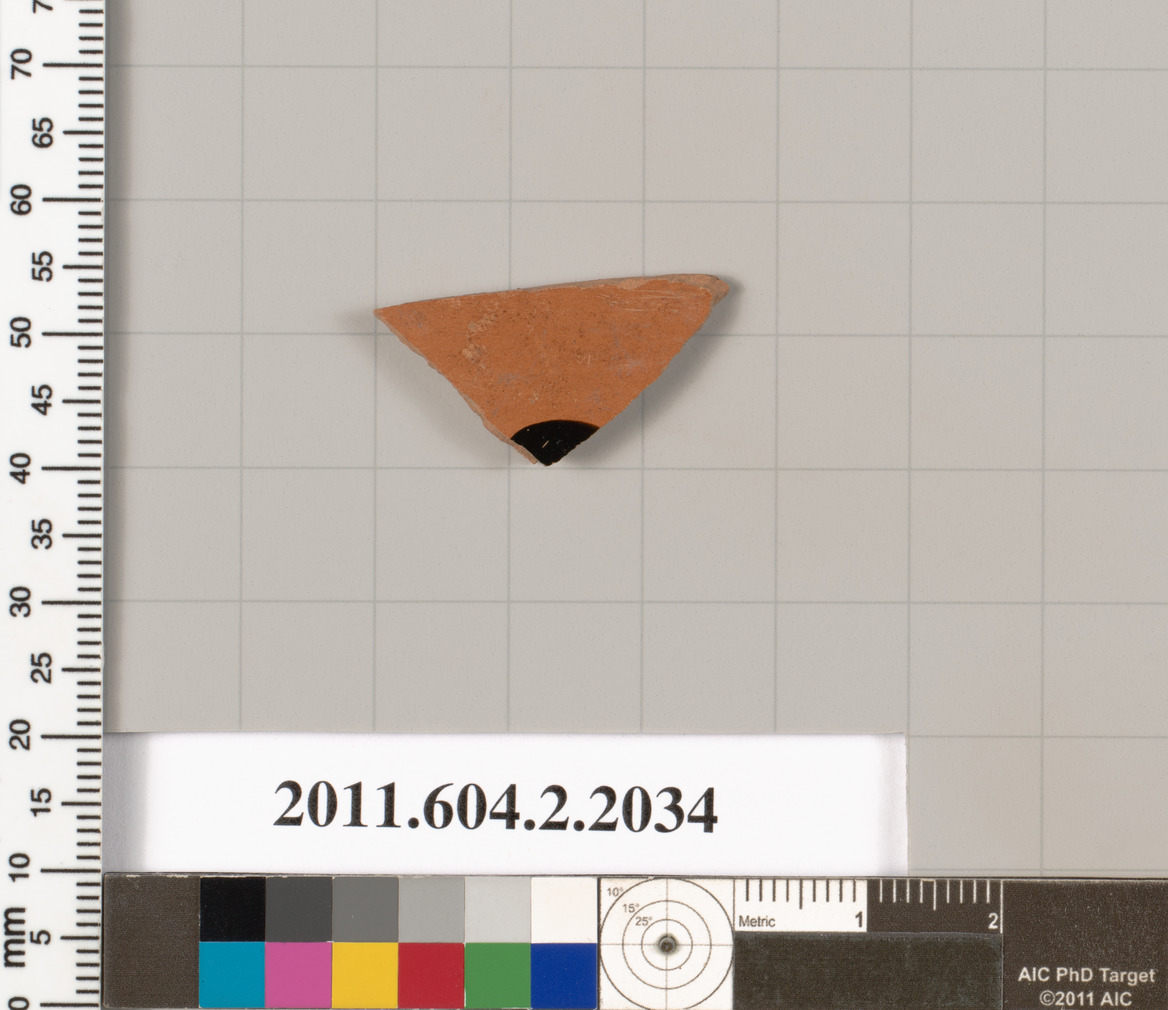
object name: pot fragment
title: Terracotta fragment of a pot; unglazed on the inside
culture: greek, attic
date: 500-401 BCE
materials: terracotta